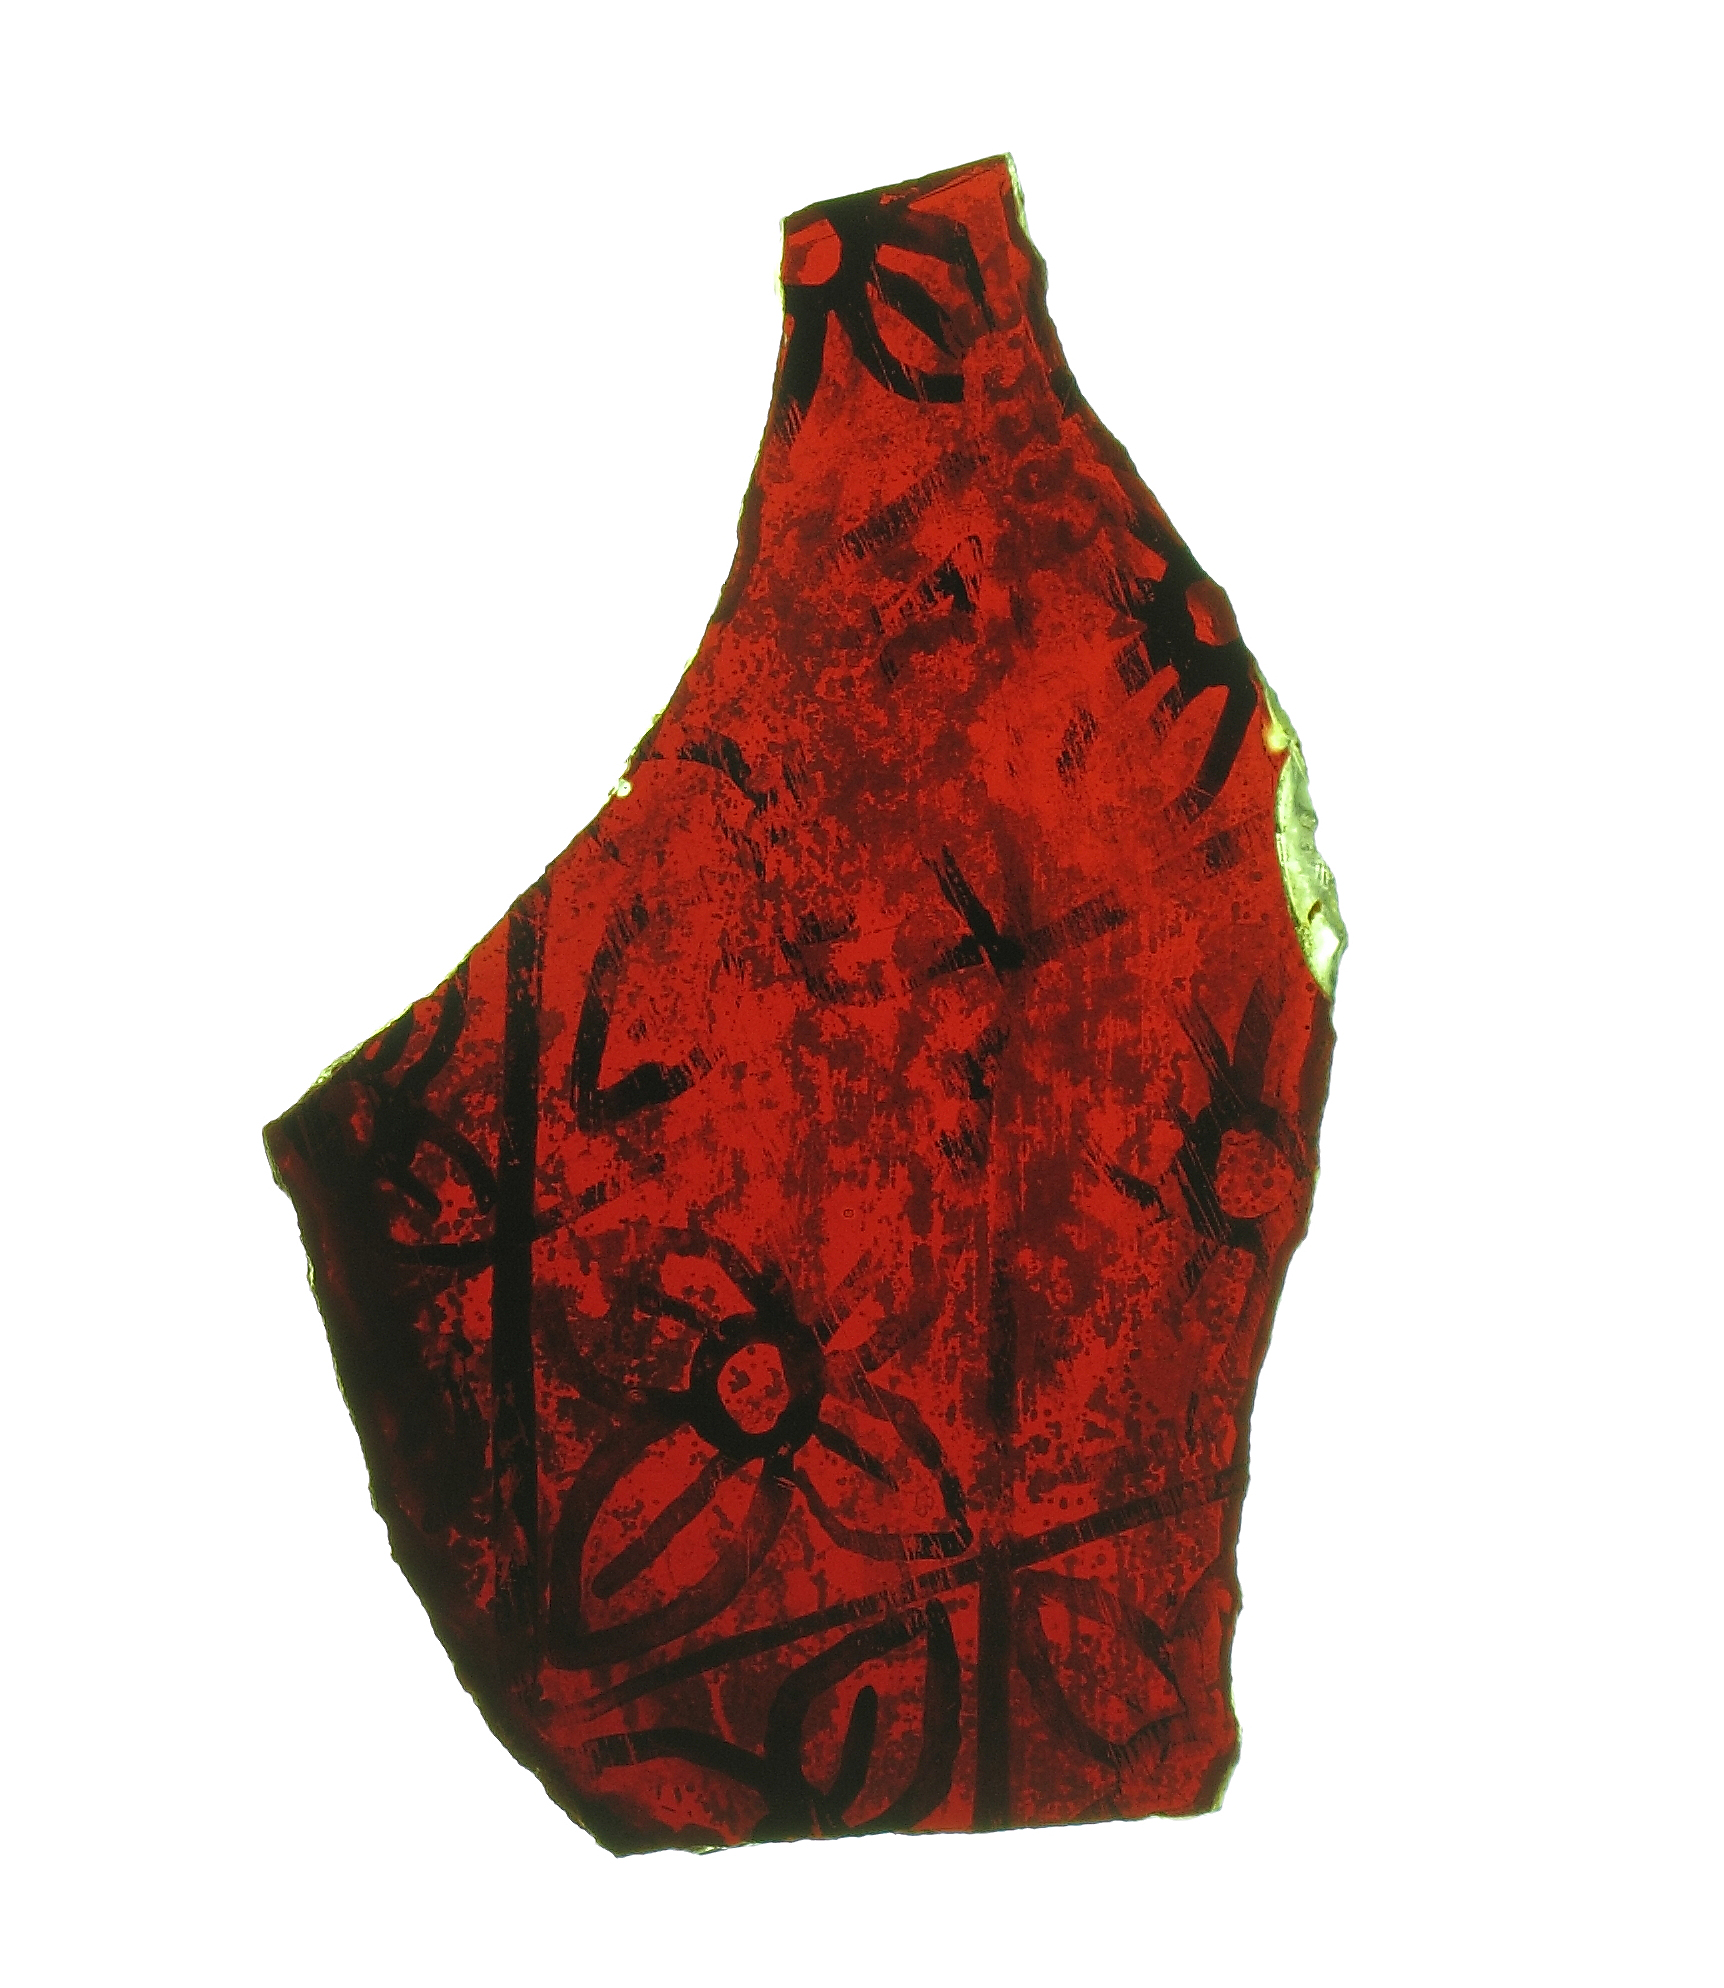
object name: fragment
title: Glass Fragment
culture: french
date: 1301-1500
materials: glass, metal